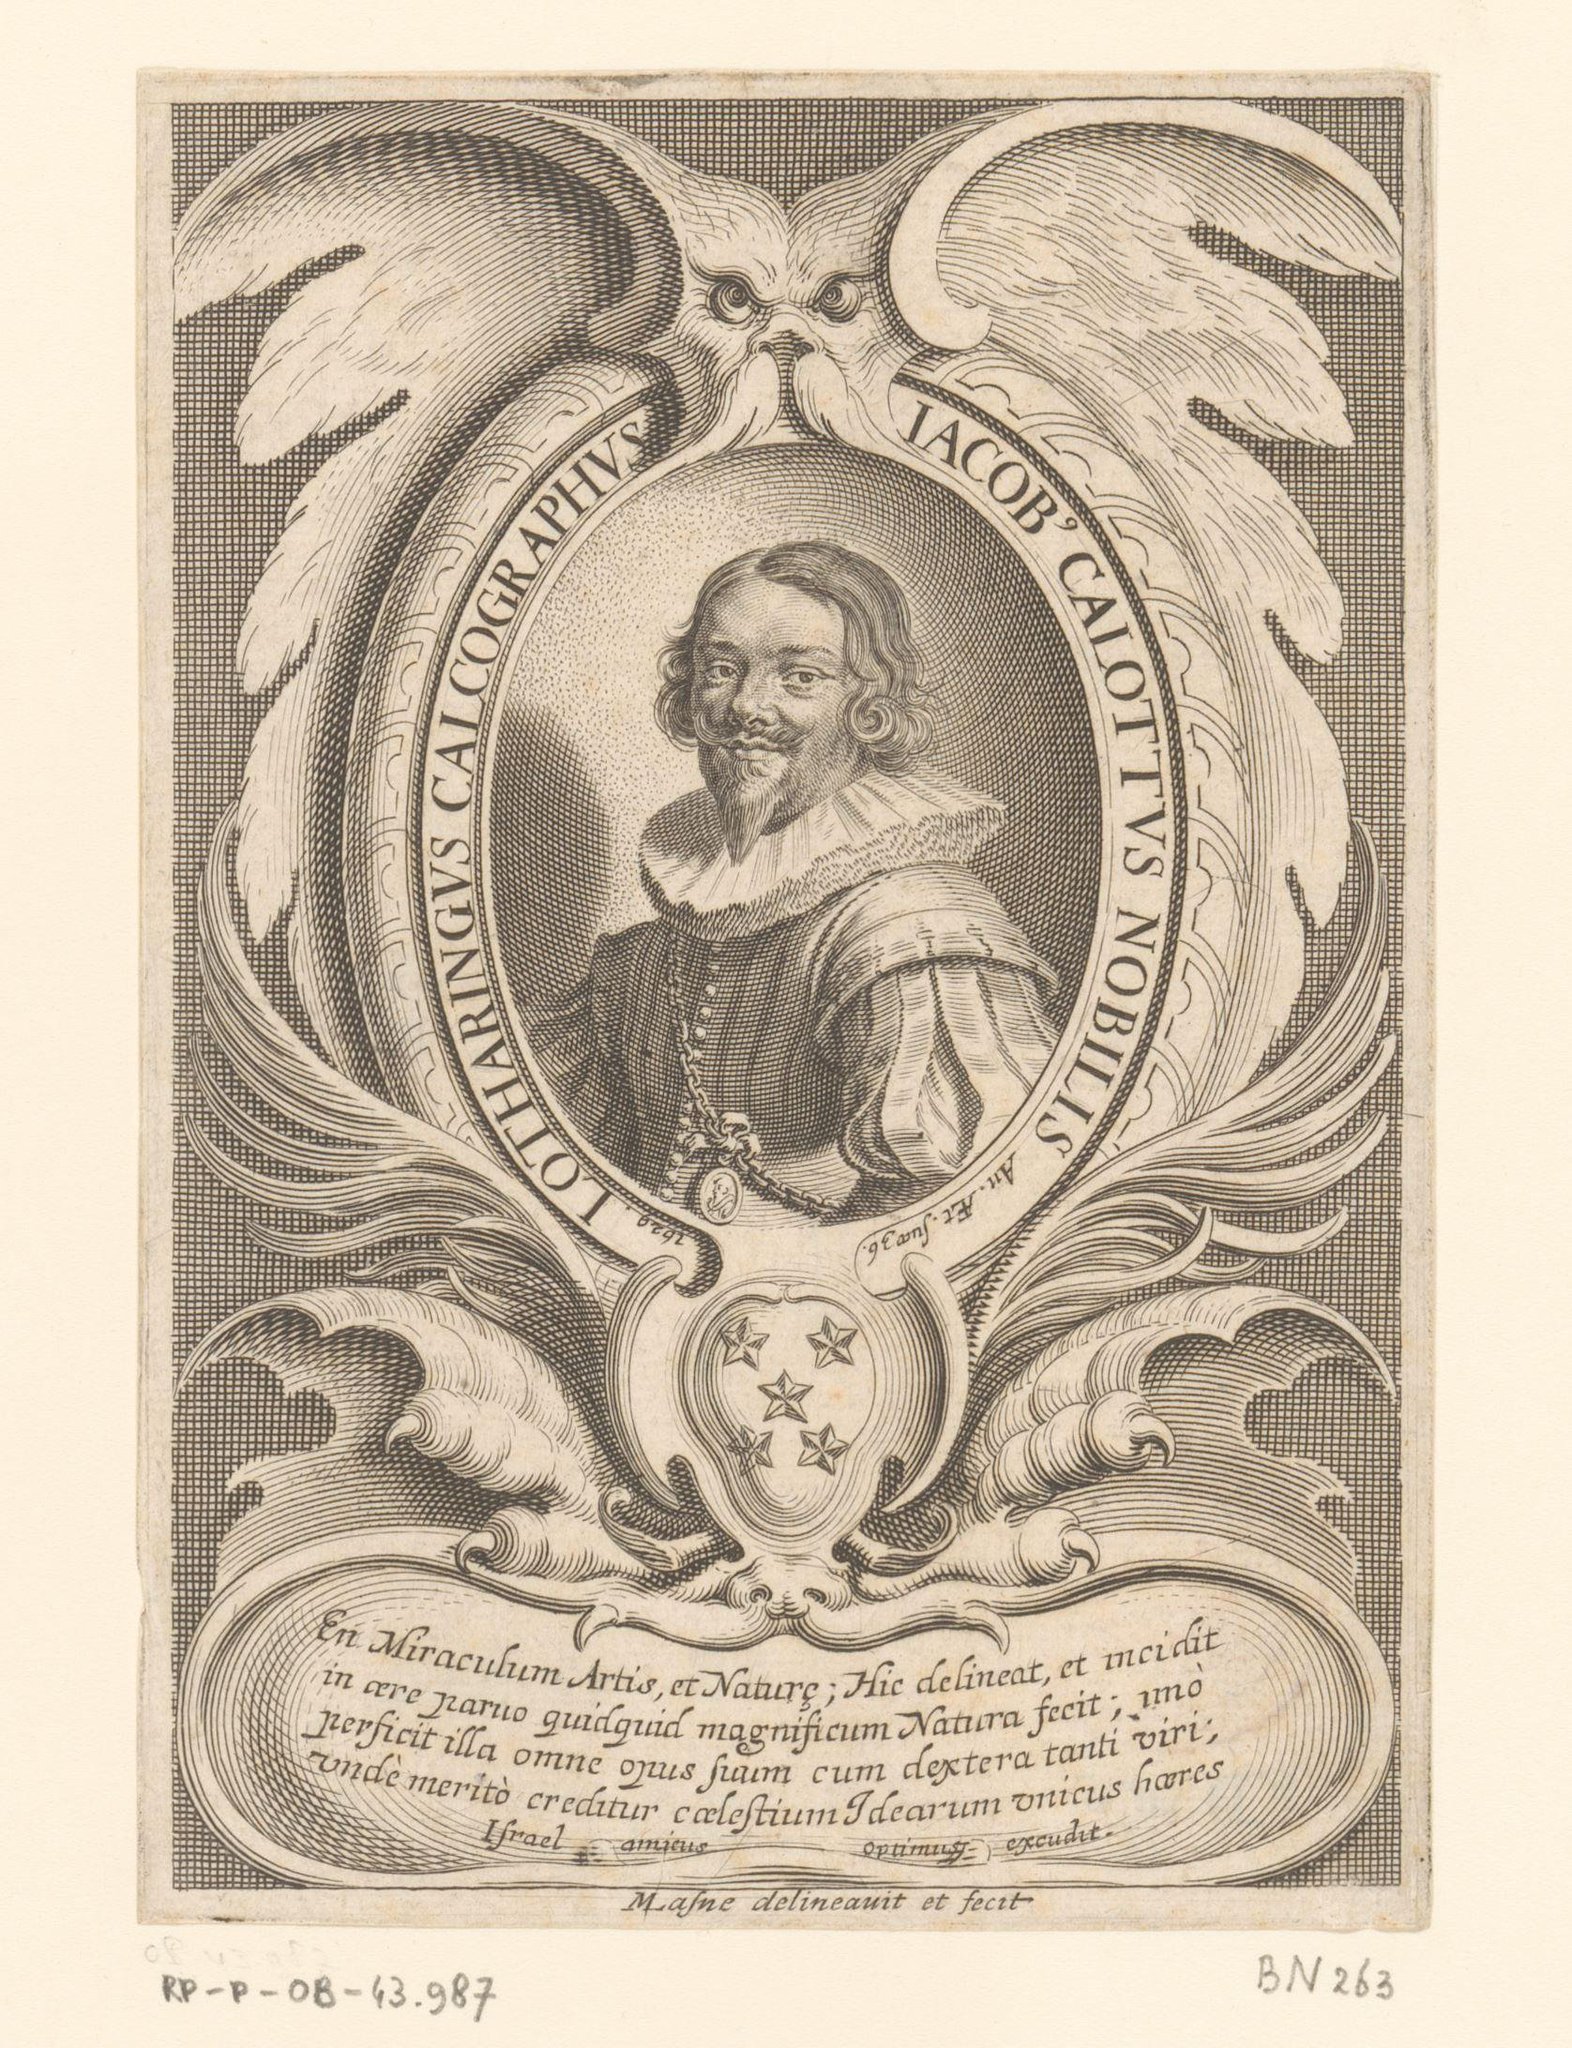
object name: print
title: Portret van Jacques Callot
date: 1629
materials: paper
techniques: engraving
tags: print maker, draughtsman, jacques callot, auricular ornament, lobe style ~ ornament, historical persons, portrait, self-portrait of artist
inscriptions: collector's mark: Lugt 240